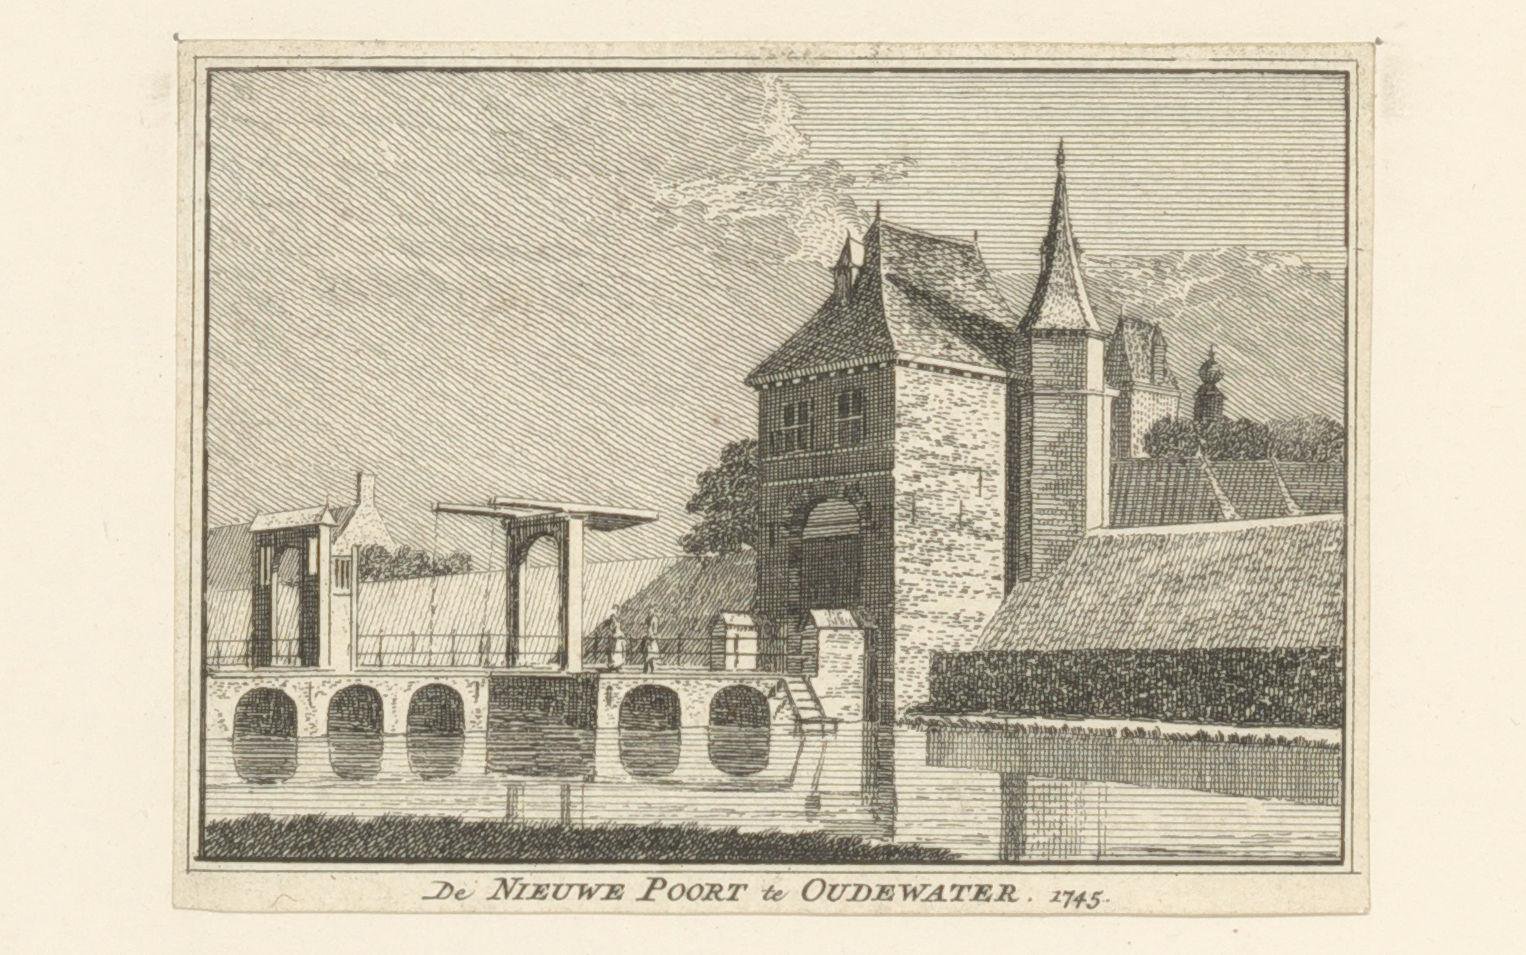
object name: print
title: De Nieuwe Poort te Oudewater, 1745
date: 1745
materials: paper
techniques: engraving, etching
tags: bridge, city-gate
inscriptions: collector's mark: Lugt 1641, stamp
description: Prent waarschijnlijk uit: Het Verheerlykt Nederland of kabinet van hedendaagsche gezigten (...). Amsterdam: Isaak Tirion, 1745, dl. 1. Of uit: Nederlandsche tafereelen; of eene keurige verzameling van negen honderd fraaije gezigten van steden, dorpen, sloten, oudheden (….). 9 dln. Amsterdam: Jan de Groot, 1792, dl. 3, ill. 254. Zie RP-T-1888-A-1828 en RP-T-1888-A-1829 voor de tekening waar deze prent op is gebaseerd.